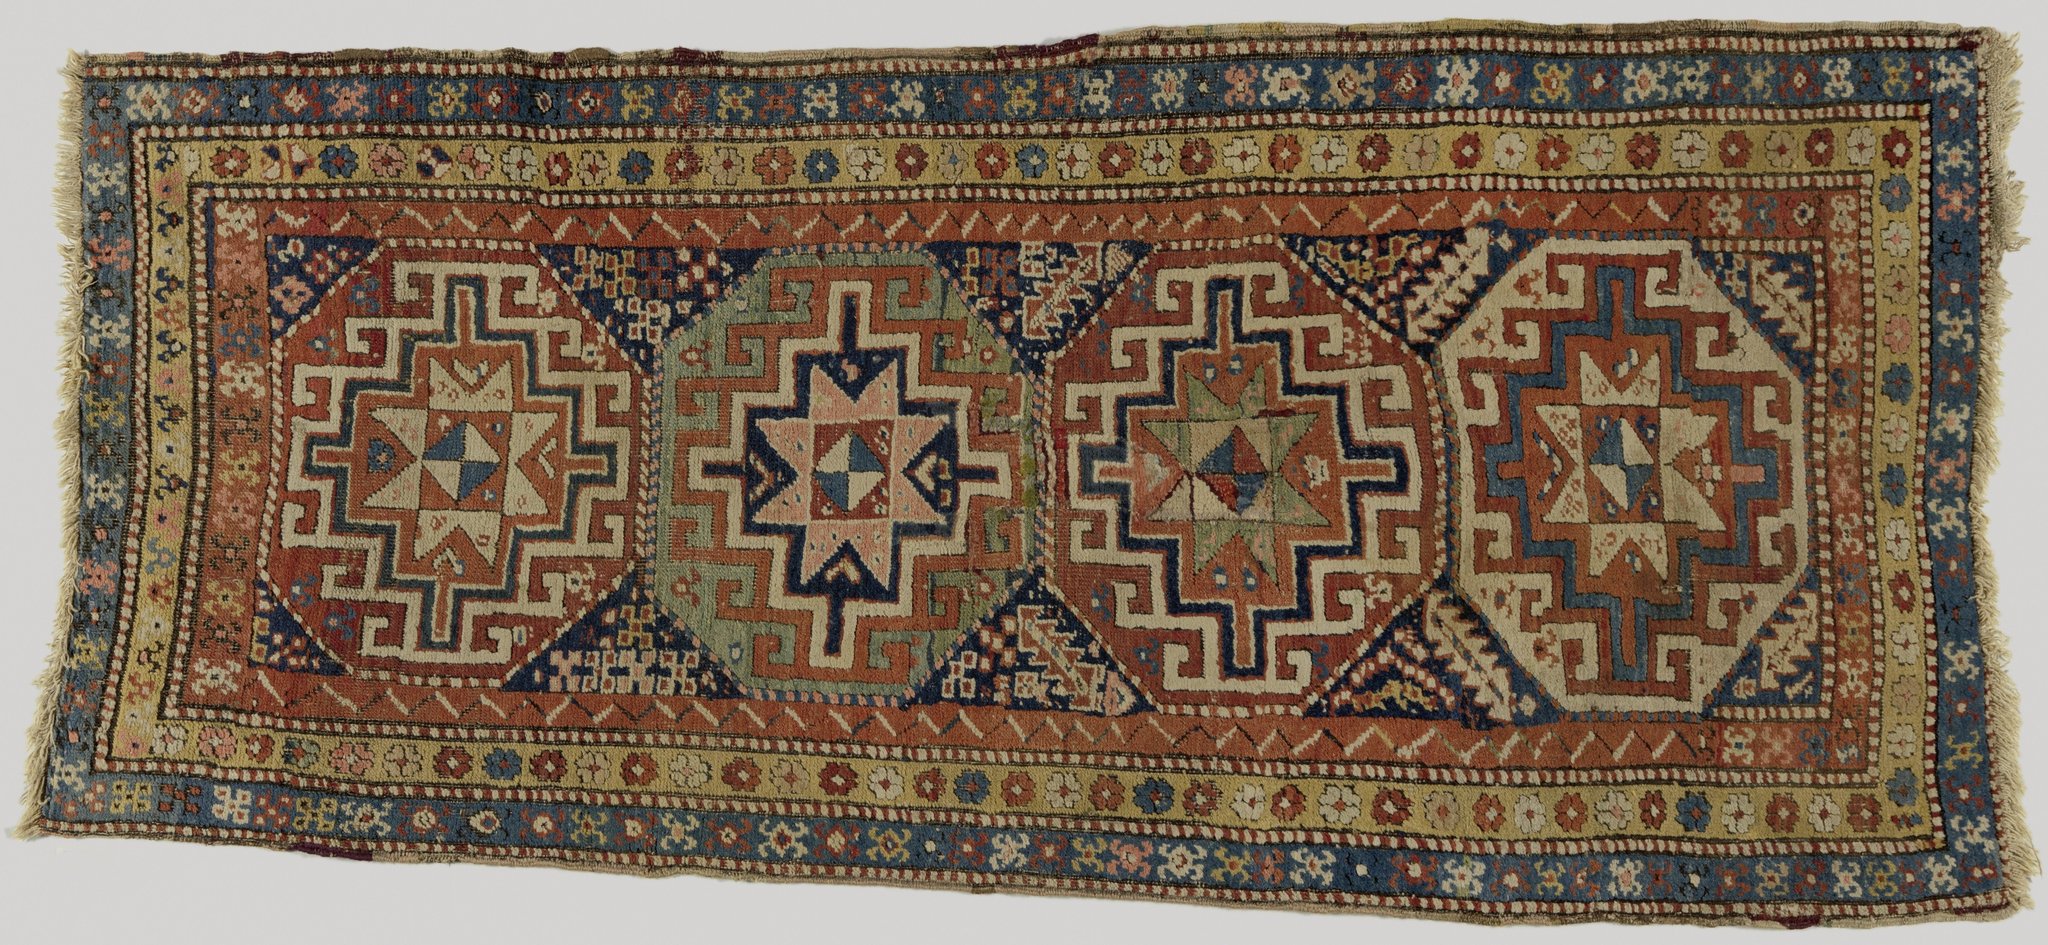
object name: perkenkleed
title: Perkenkleed, KARABAGH of SHIRWAN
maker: Anonymous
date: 1800-1900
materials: wool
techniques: ghiordes knot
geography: karabakh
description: Perkenkleed, Karabagh of Shirwan. Middenveld: donkerblauw fond met vier op elkaar staande en de volle breedte beslaande achthoeken. De kleuren zijn wit, gebrande Sienna, zeegroen en nogeens gebrande Sienna. In elk staat een trapgevelblok in blauw, rood en wit met buitenwaartse haken. In de zwikken strooigoed. Rand: drievoudig. Drie even smalle randen zijn resp. rood, geel en blauw en gevuld met zigzaglijnen, rozetten en krabmotieven.